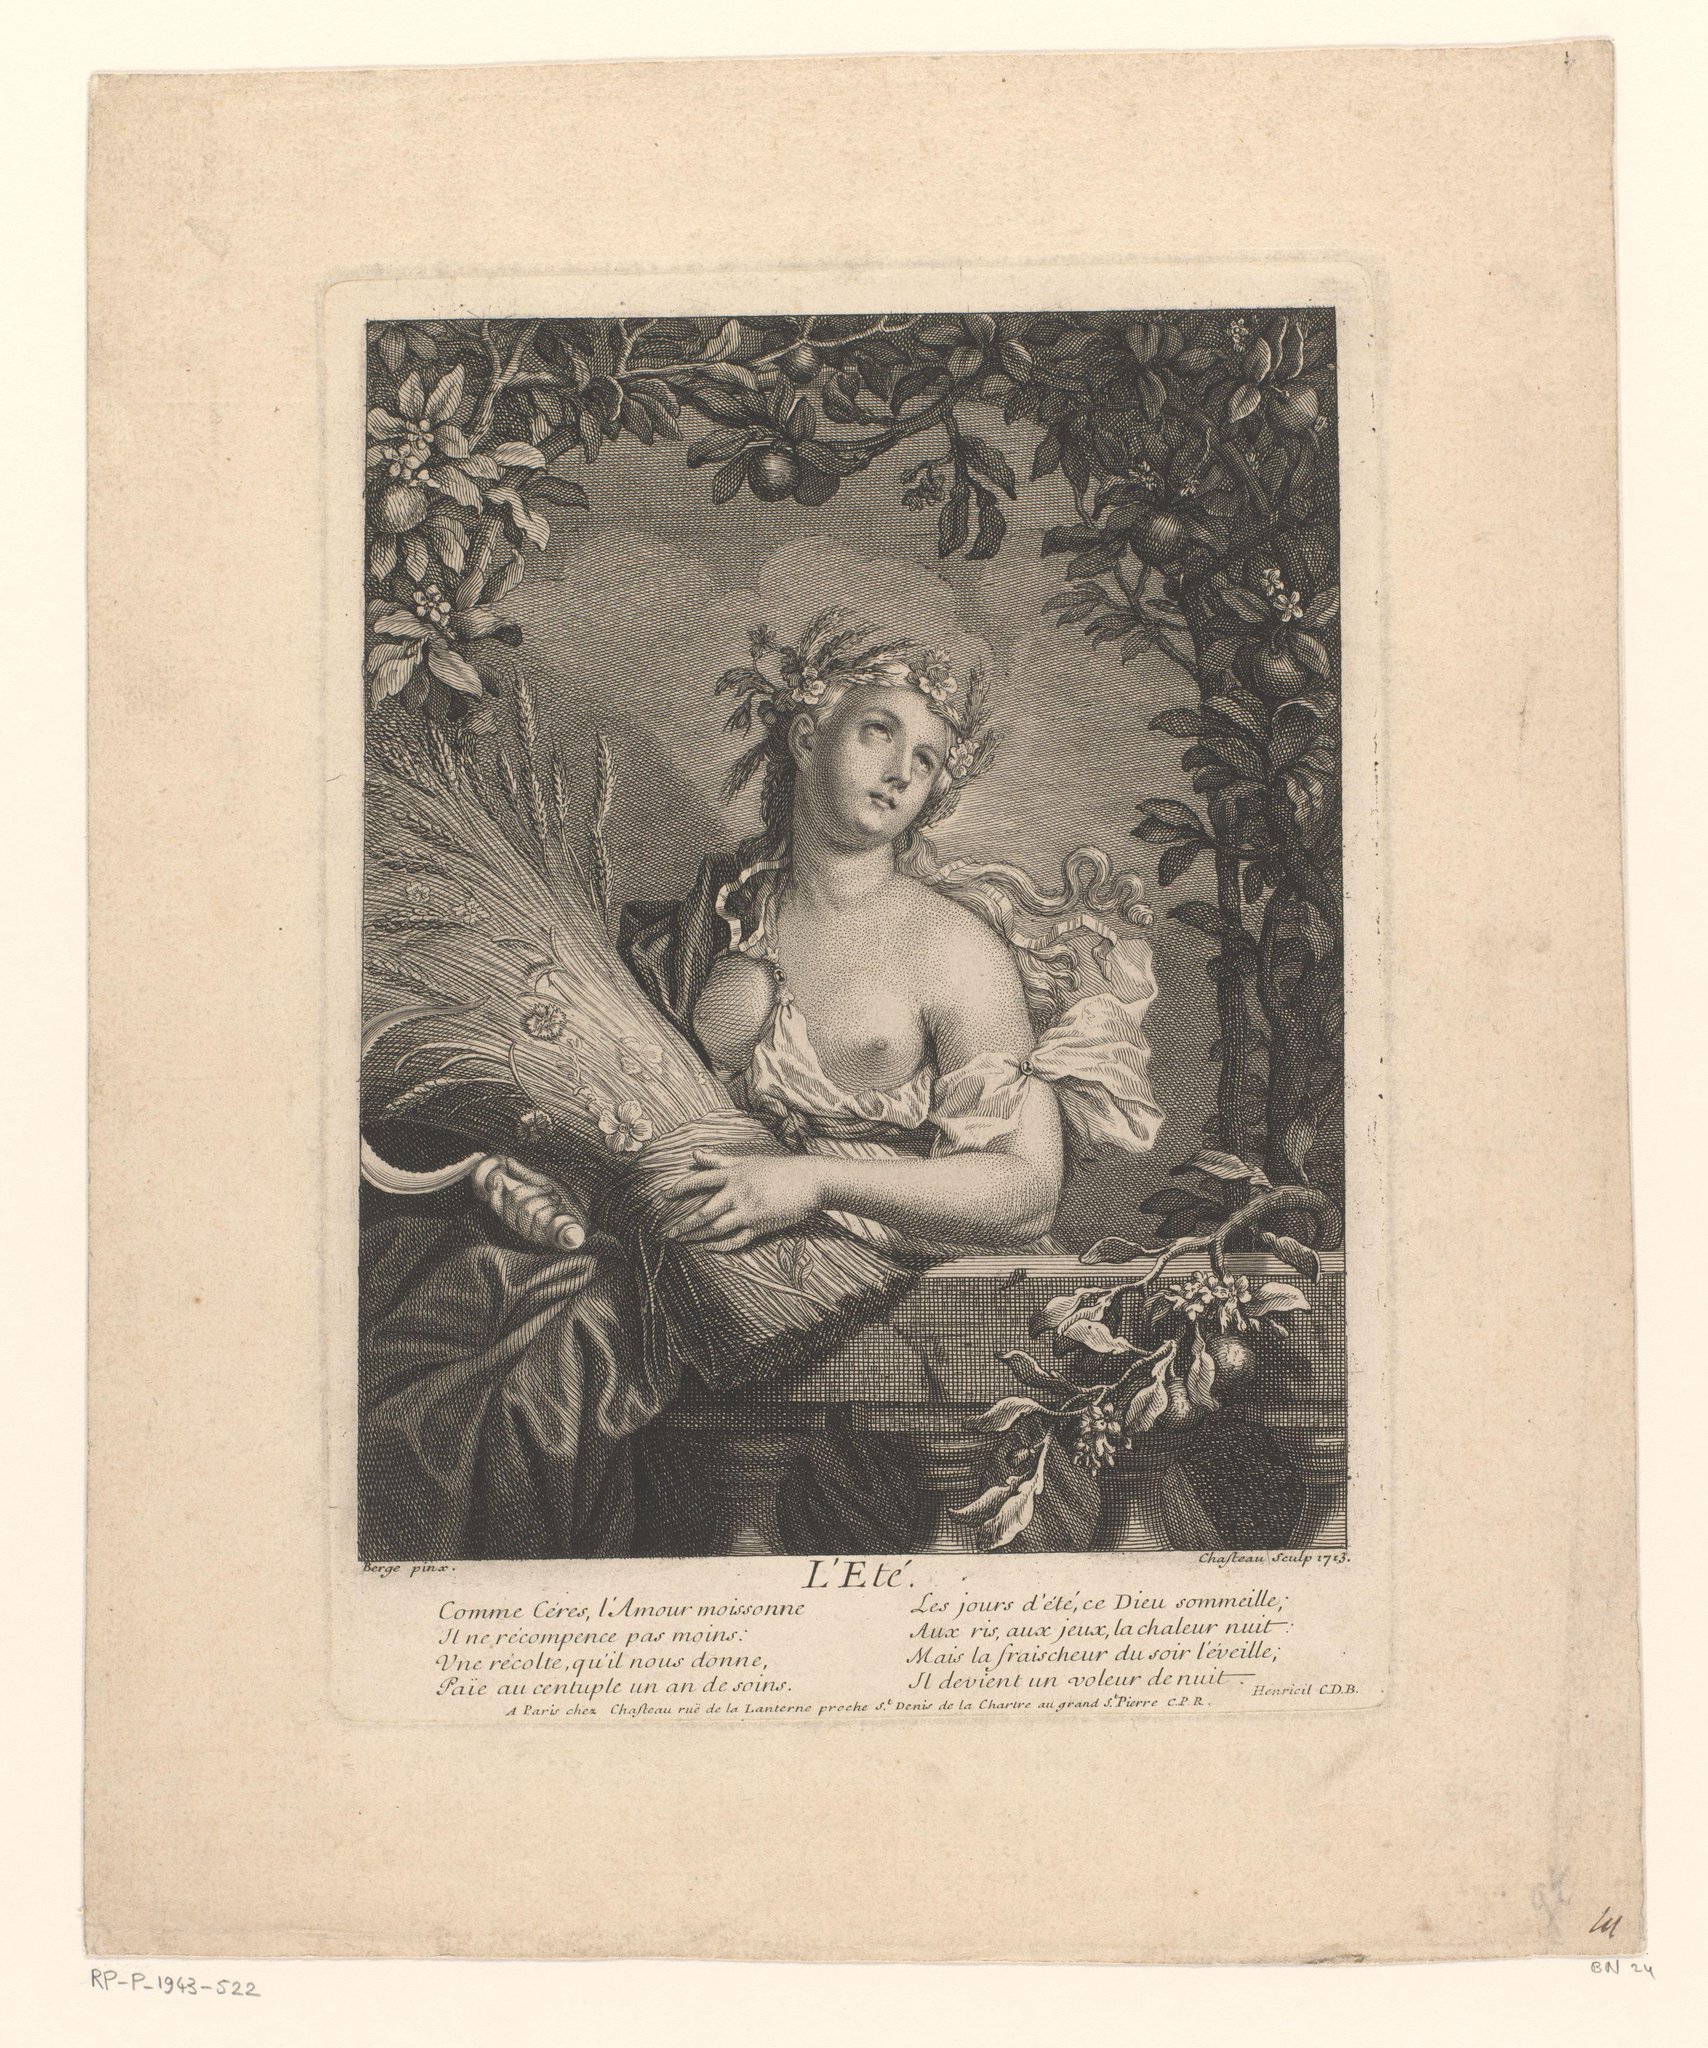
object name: print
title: Zomer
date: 1713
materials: paper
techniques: engraving, etching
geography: paris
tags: summer, 'aestas'; 'estate' (ripa)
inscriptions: collector's mark: Lugt 2228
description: Maakt deel uit van een vierdelige serie met personificaties van de vier seizoenen, uitgegeven in 1713 door de prentmaker in Parijs.